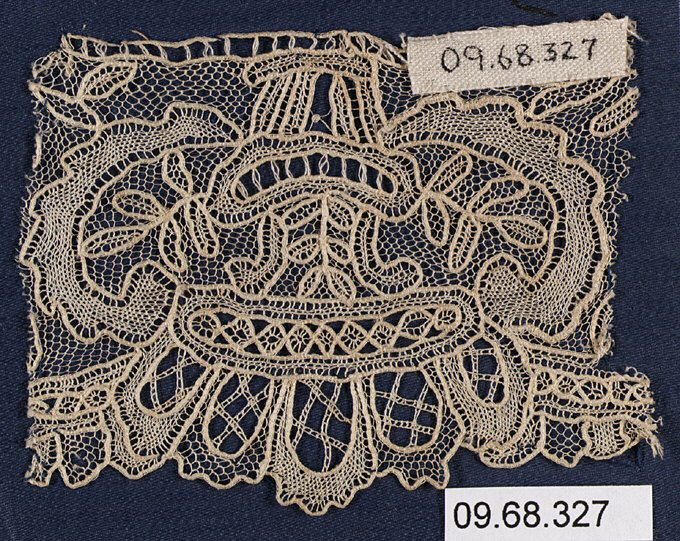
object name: fragment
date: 1801-1900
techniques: lace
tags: leaves